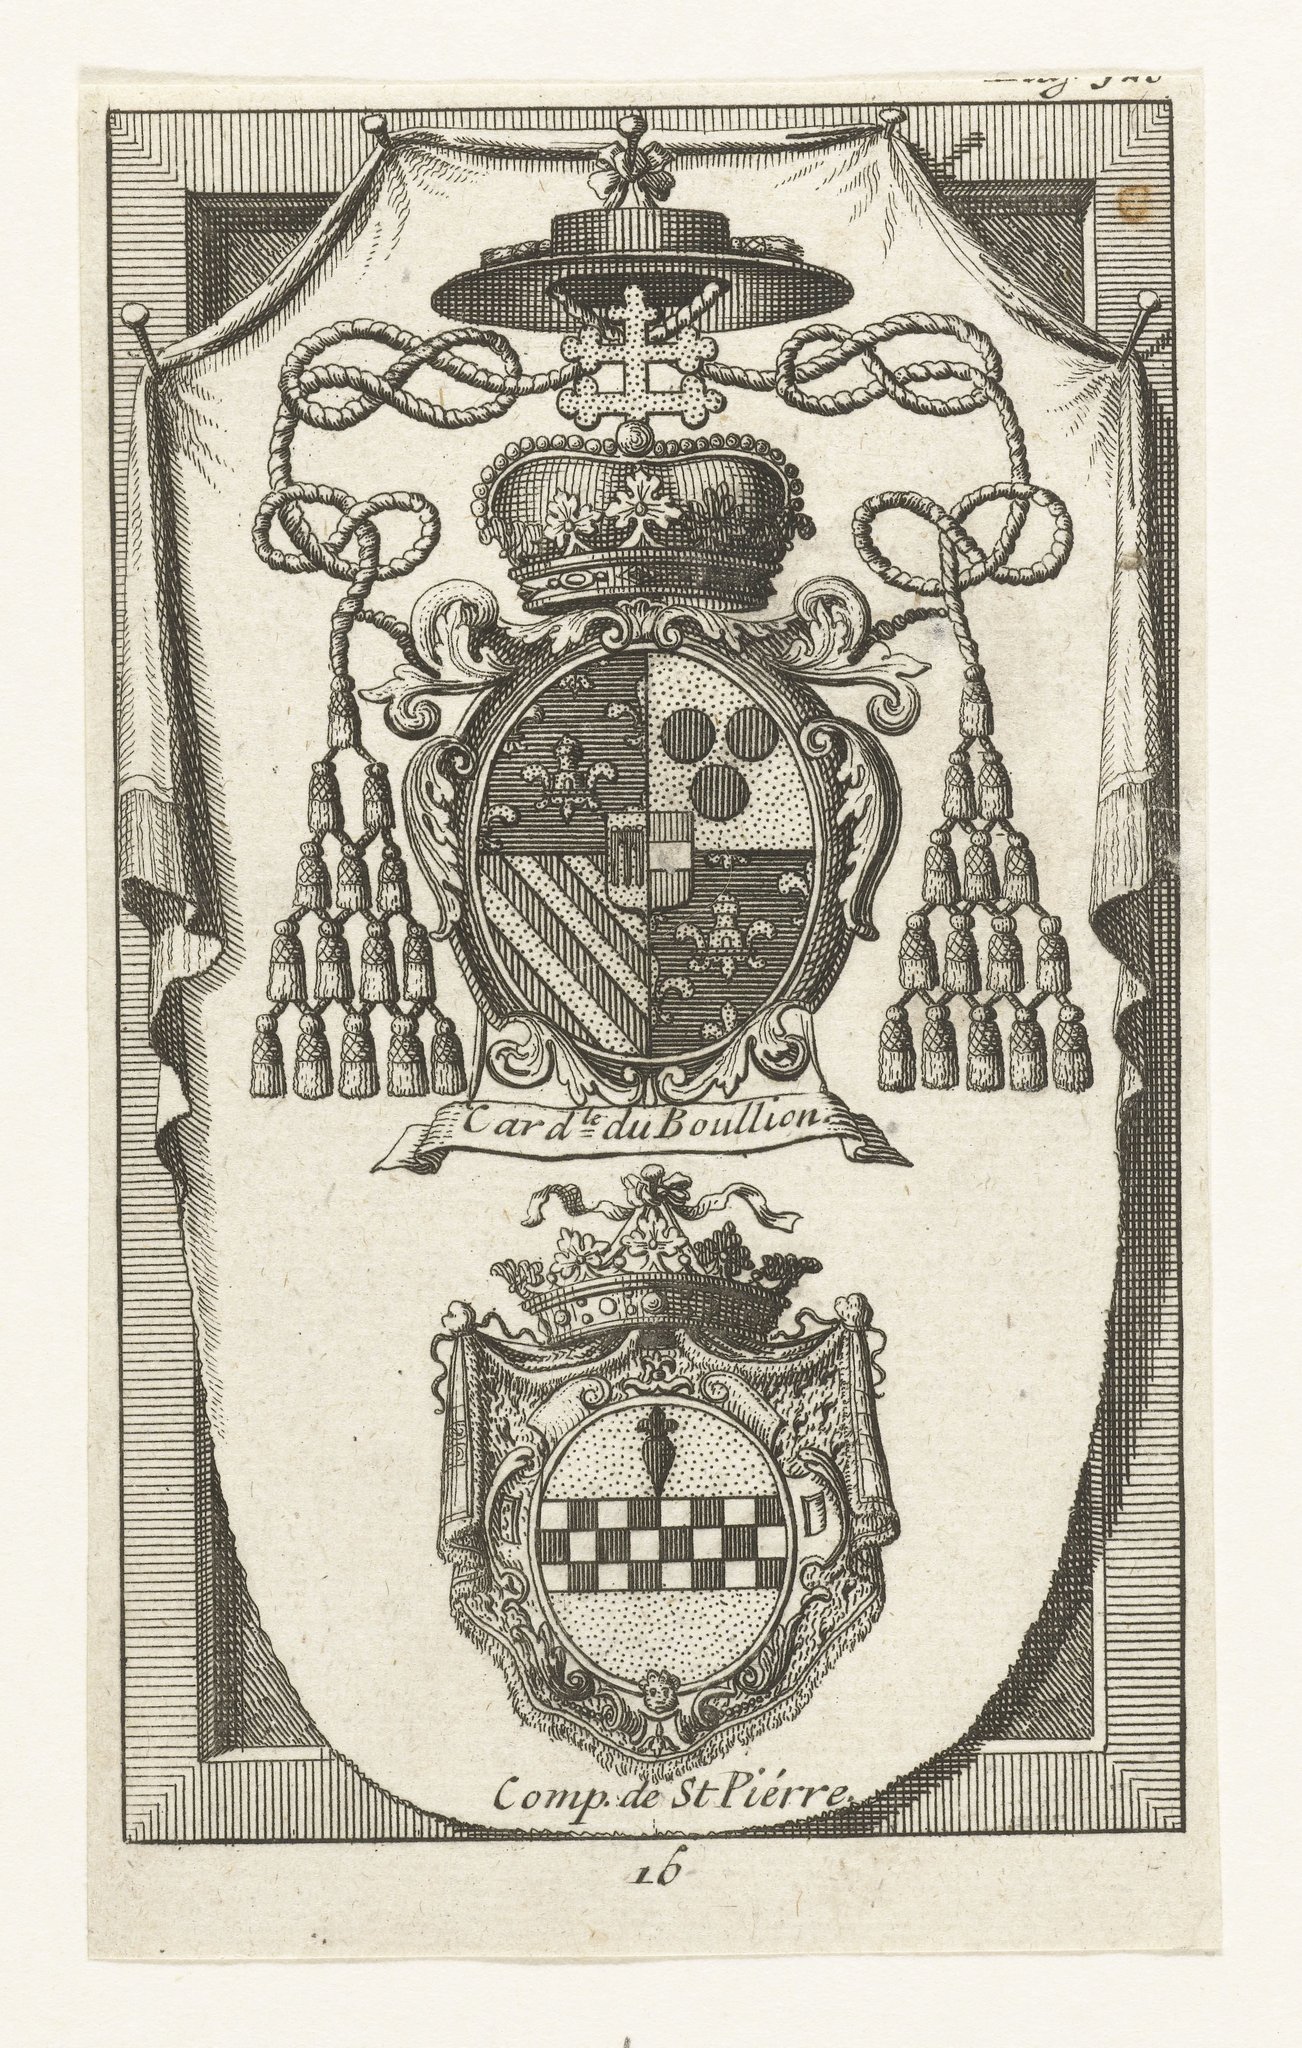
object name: print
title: Wapens van de gevolmachtigden van de kardinaal van Boullion de Comp. de St. Pierre bij de vredesonderhandelingen te Utrecht (nr. 16), 1712-1713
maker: Anonymous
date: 1713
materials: paper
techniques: etching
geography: northern netherlands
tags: weapons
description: Wapens van de gevolmachtigden van de kardinaal van Boullion en van de Comp. de St. Pierre. Blad nummer 16 in een groep van 16 prenten met de wapens en namen van de gevolmachtigden bij de vredesonderhandelingen te Utrecht, 1712-1713.